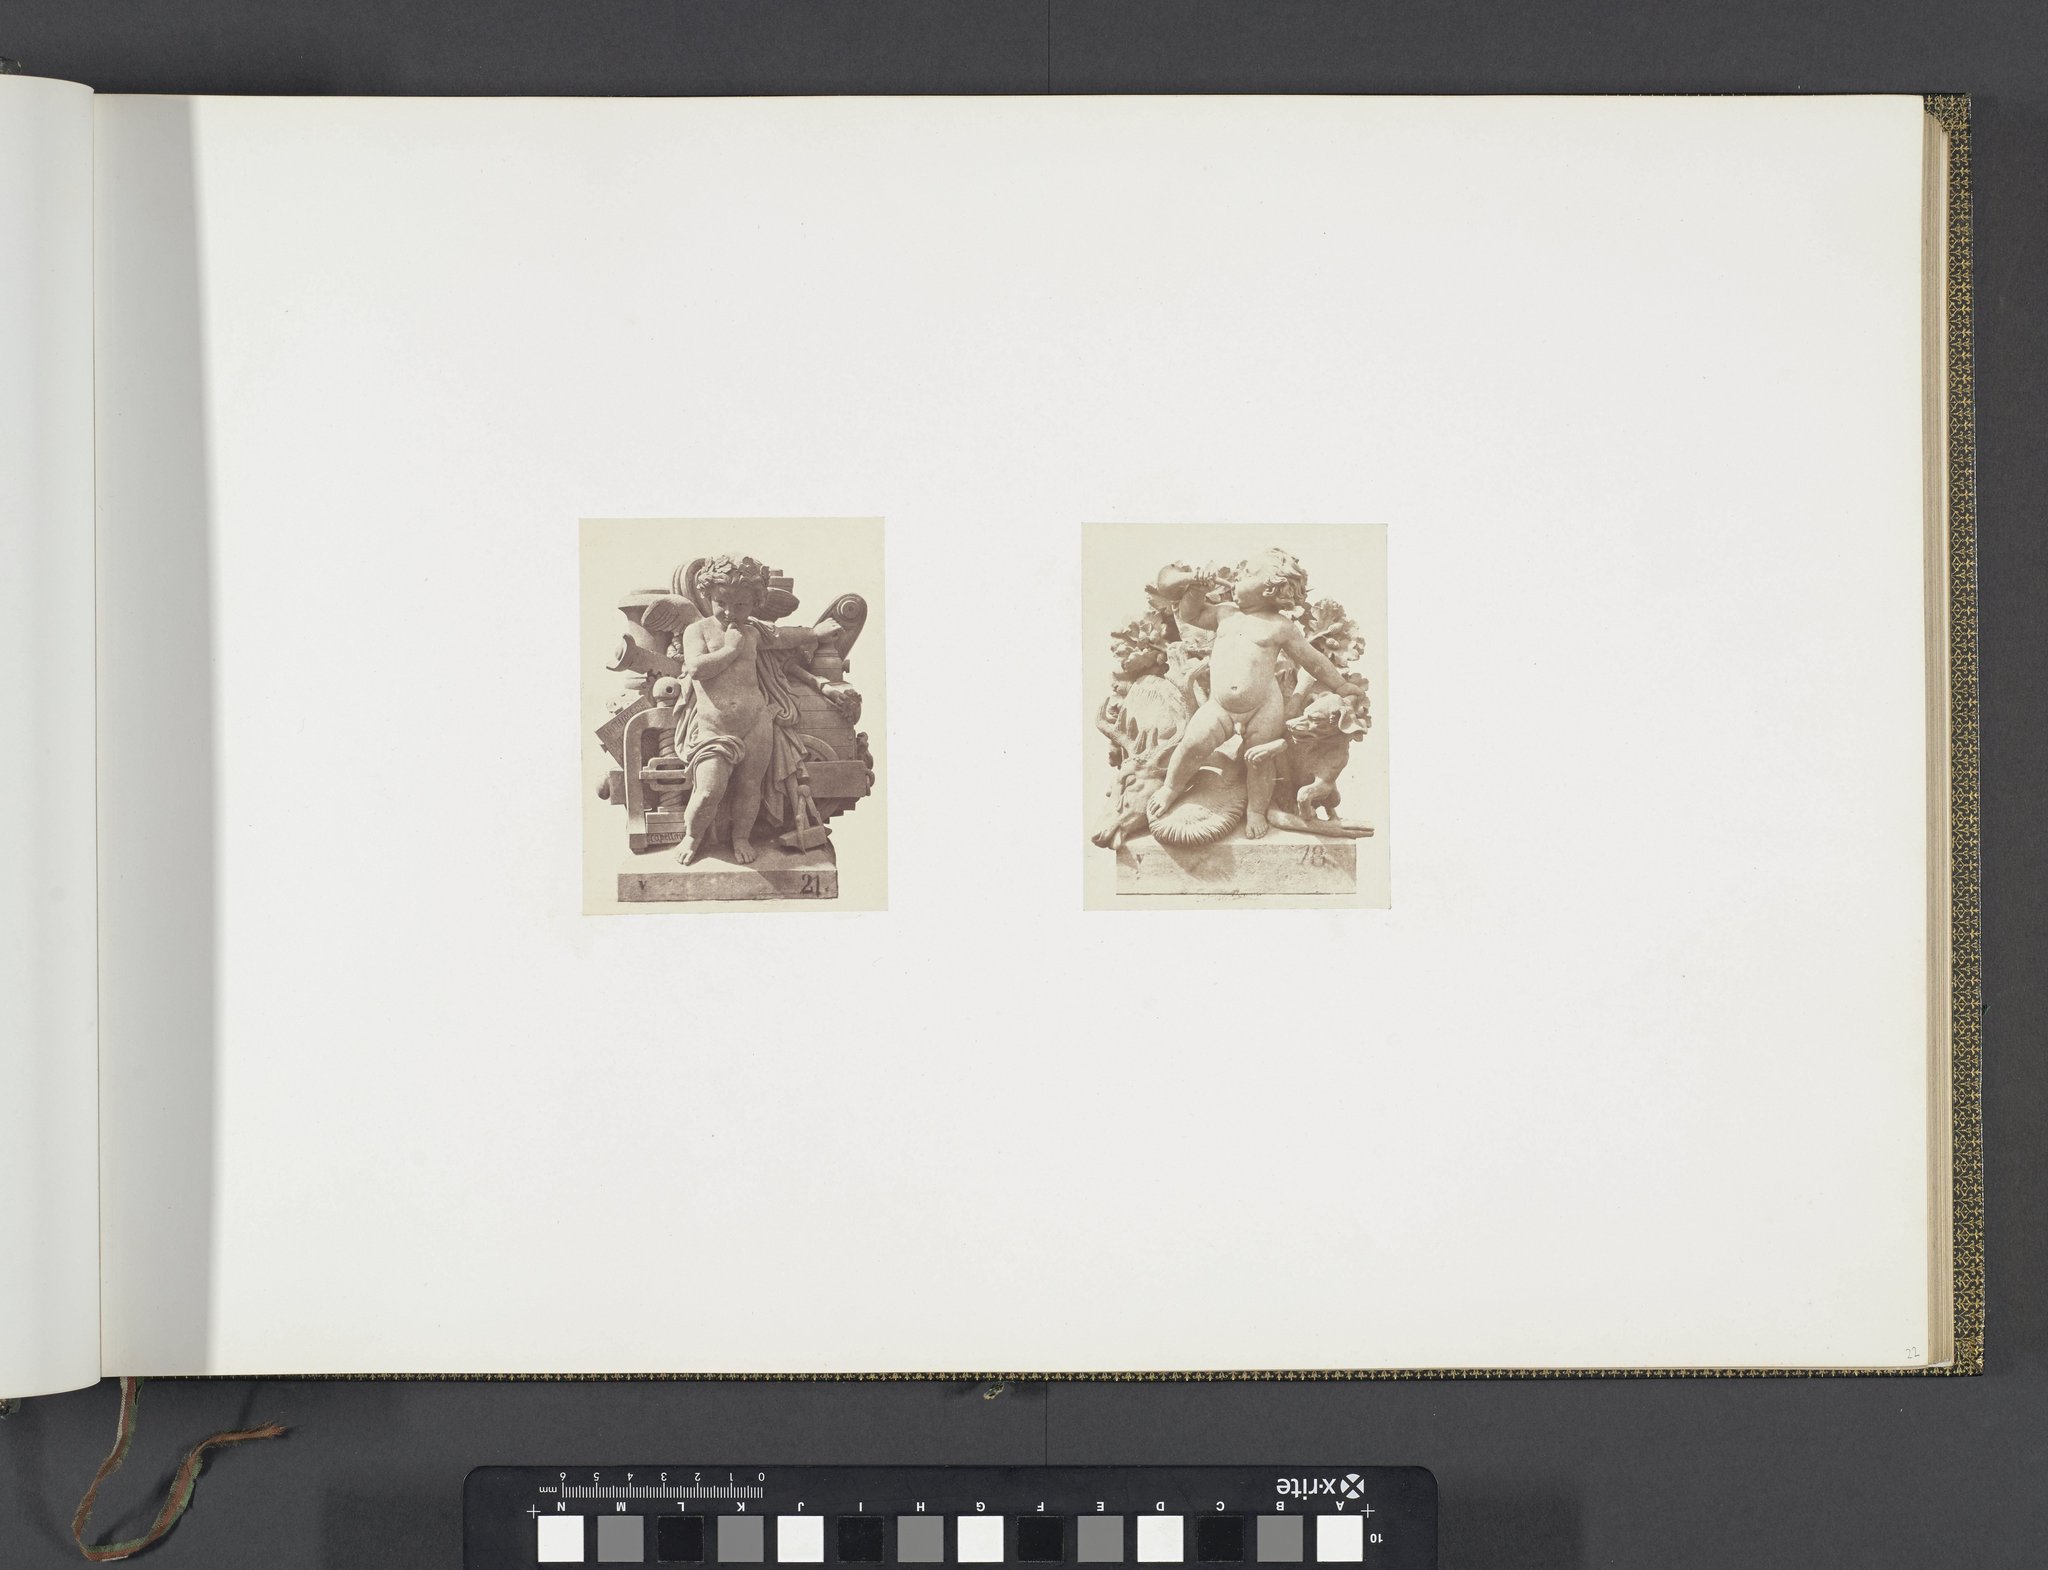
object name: album leaf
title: Gipsmodellen voor beeldhouwwerken op het Palais du Louvre: links "La Mécanique" door Charles Capellaro en rechts "La Chasse" door Auguste Jean Baptiste Lechesne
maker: édouard denis baldus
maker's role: fotograaf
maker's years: 1813-1889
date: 1855-1857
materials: paper, photographic support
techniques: salted paper print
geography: paris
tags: piece of sculpture, reproduction of a piece of sculpture, permanent exhibition, museum, paris, tuileries palace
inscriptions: number: ‘21 en 18’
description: Onderdeel van Réunion des Tuileries au Louvre 1852-1857, album 1.